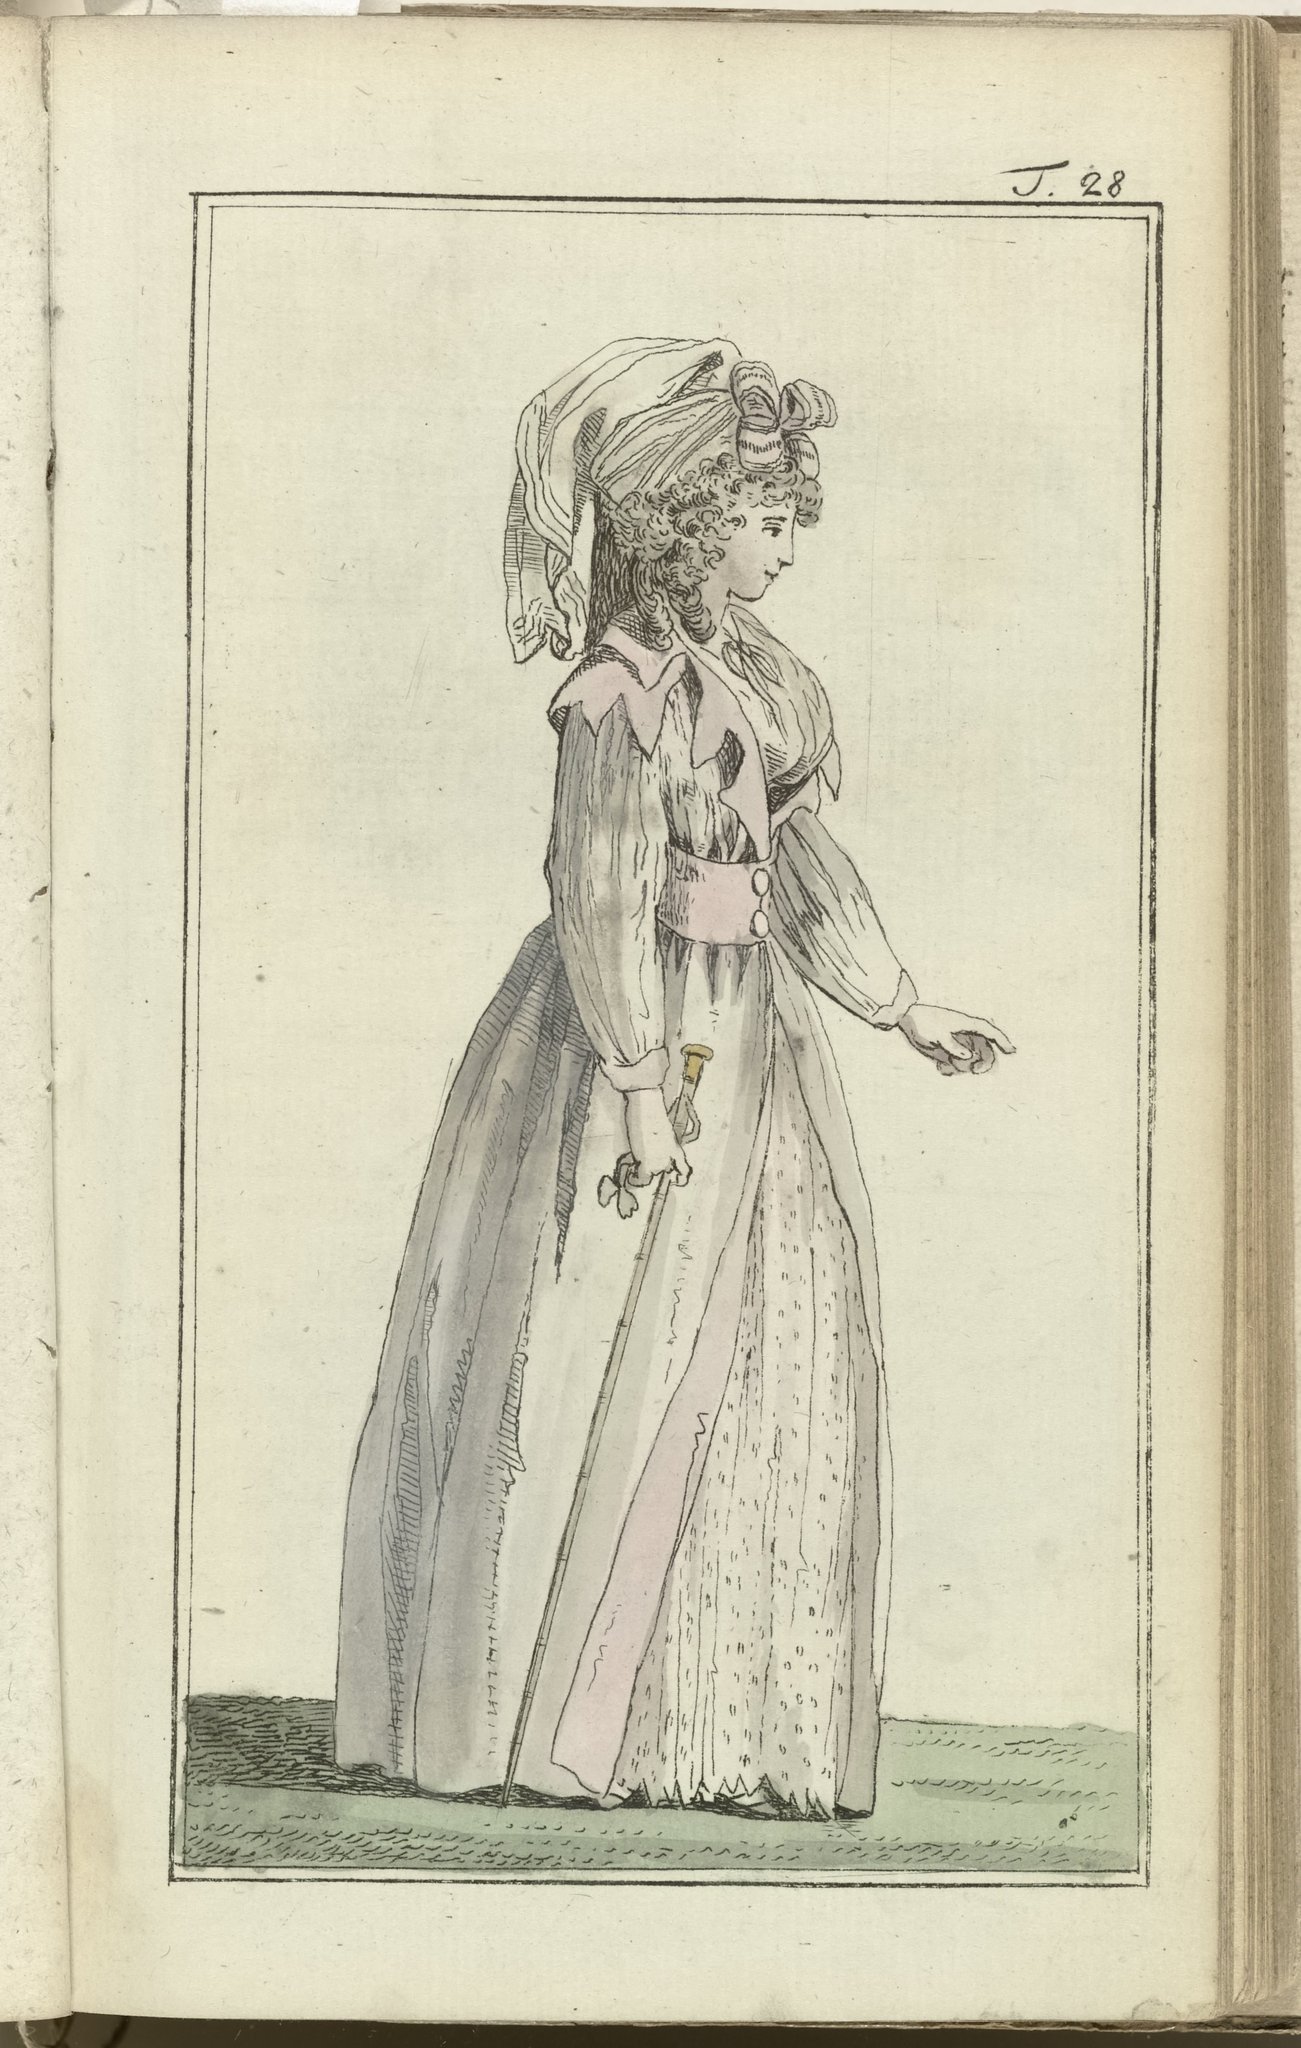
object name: fashion print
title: Journal des Luxus und der Moden 1788, Band III, T.28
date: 1788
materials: paper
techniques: etching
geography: weimar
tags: fashion plates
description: Prent uit het modetijdschrift Journal des Luxus und der Moden, uitgegeven door Friedrich Justin Bertuch en Georg Melchior Kraus, Weimar, 1786-1826.